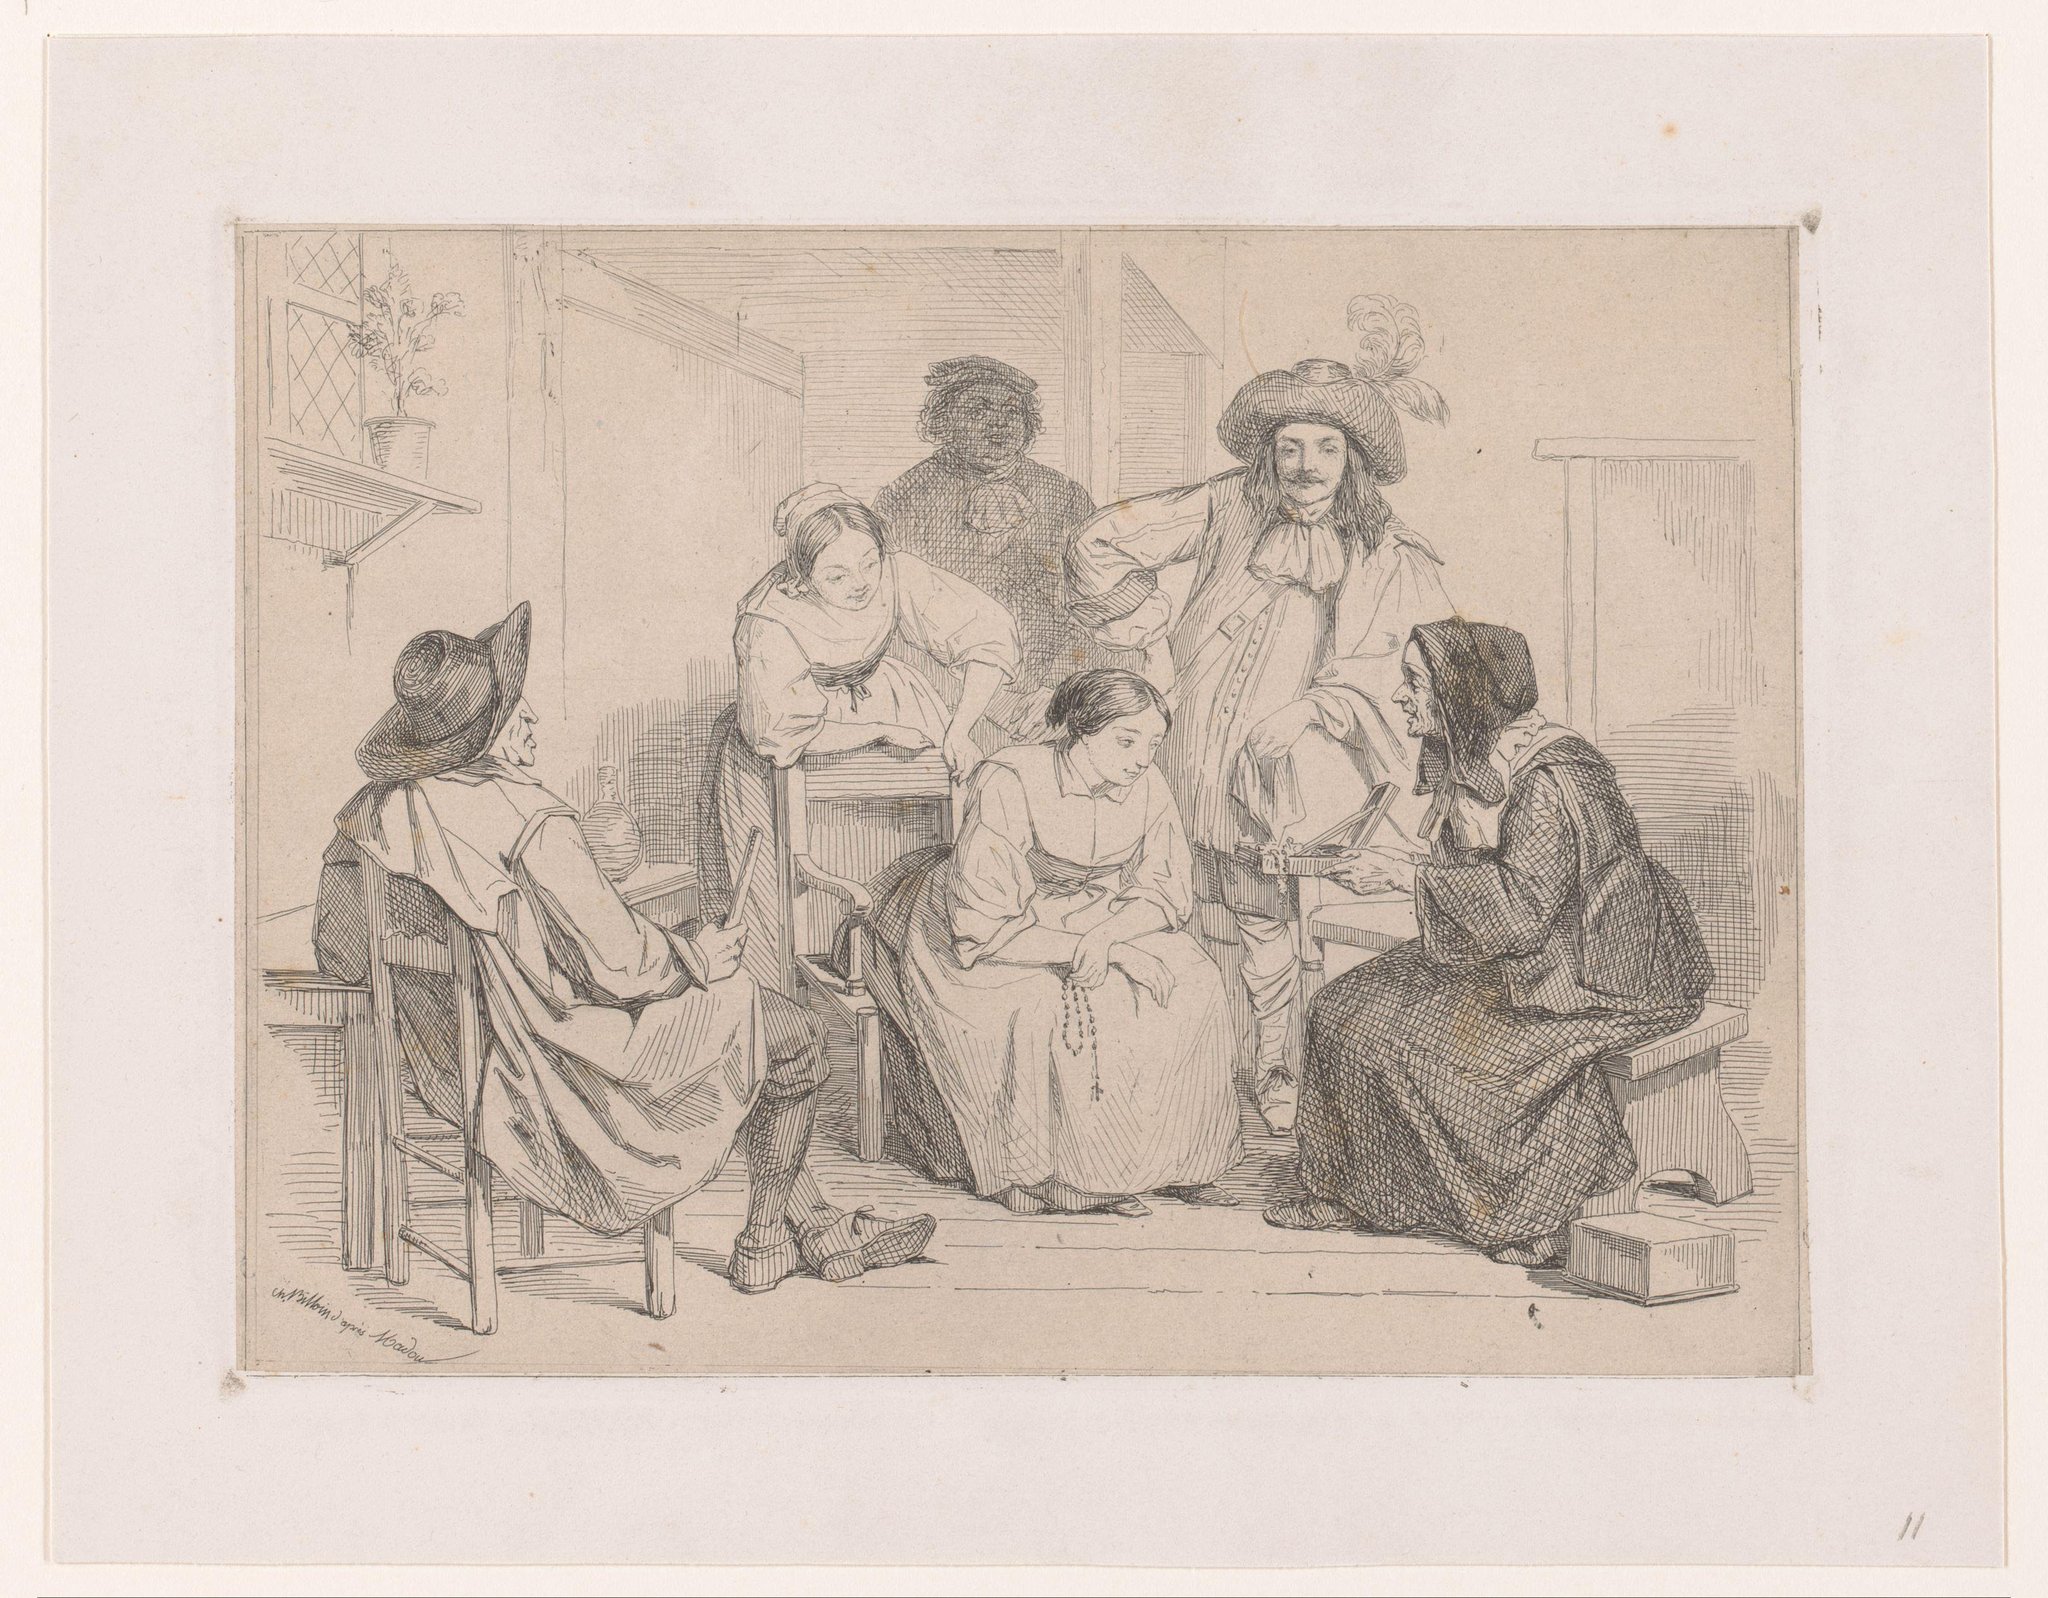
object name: print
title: Verkoopster van rozenkransen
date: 1850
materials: paper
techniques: etching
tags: aids for prayer, e.g. rosary, merchant, salesman - bb - women engaged in trade and commerce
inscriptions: collector's mark: Lugt 2228, collector's mark: Lugt 1485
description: Mogelijk komt deze prent uit: Les peintres Belges au XIXe siècle. Brussel: Déro-Becker fils, 1850.